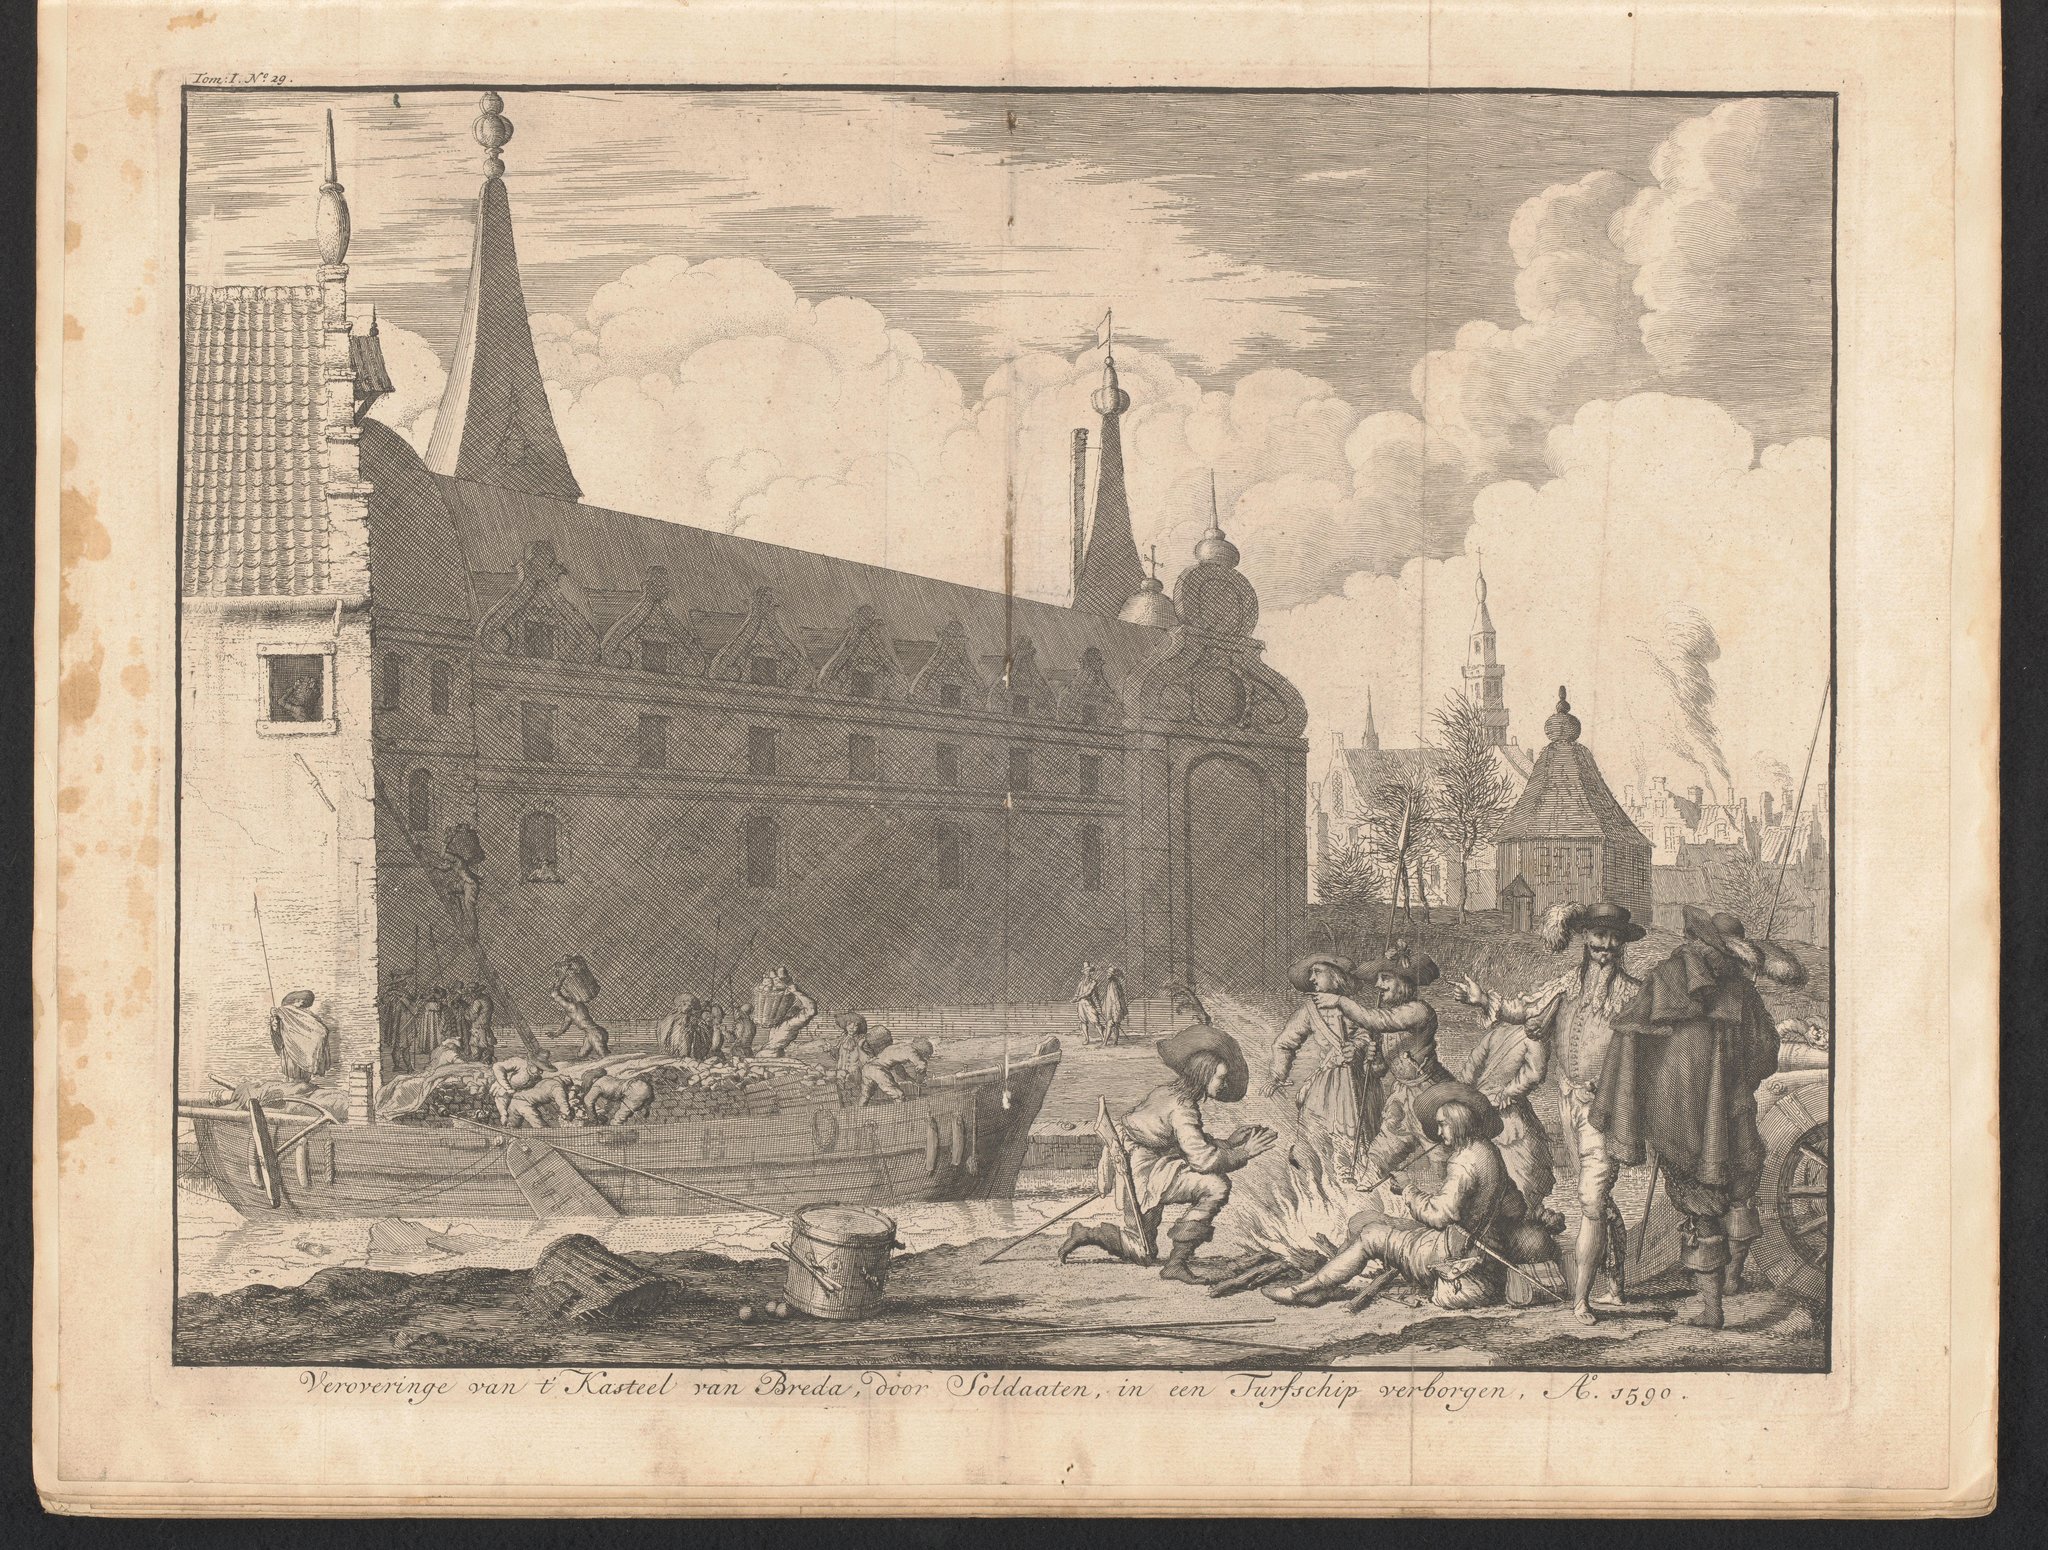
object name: print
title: Veroveringe van t' Kasteel van Breda, door Soldaten, in een Turfschip verborgen, Ao. 1590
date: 1730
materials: paper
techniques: etching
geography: northern netherlands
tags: castle, the soldier off duty, traffic and transport (+ unloading)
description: Prent waarschijnlijk uit: Le Clerc, Jean. Geschiedenissen der Vereenigde Nederlanden, sedert den aanvang van die Republyk tot op den Vrede van Utrecht in 't jaar 1713 en het Tractaat van Barriere in 't jaar 1715 gesloten. Amsterdam: Zacharias Chatelain, 1730, dl. 1, p. 212-213. Eerdere staat gebruikt in: Bor, Pieter Christiaensz. Oorsprongk, begin, en vervolgh der Nederlandsche Oorlogen (...), Amsterdam: weduwe van Joannes van Someren, Abraham Wolfgangh, Hendrick en Dirk Boom 1684, dl. 3, p. 522-523. Eerdere staat ook gebruikt in: Groot, Hugo de. Nederlandtsche Jaerboeken en Historien; sedert het jaer MDLV tot het jaer MDCIX (...). Amsterdam: weduwe Joannes van Someren, Abraham Wolfgang en Hendrick en Dirk Boom, 1681, p. 152-153.